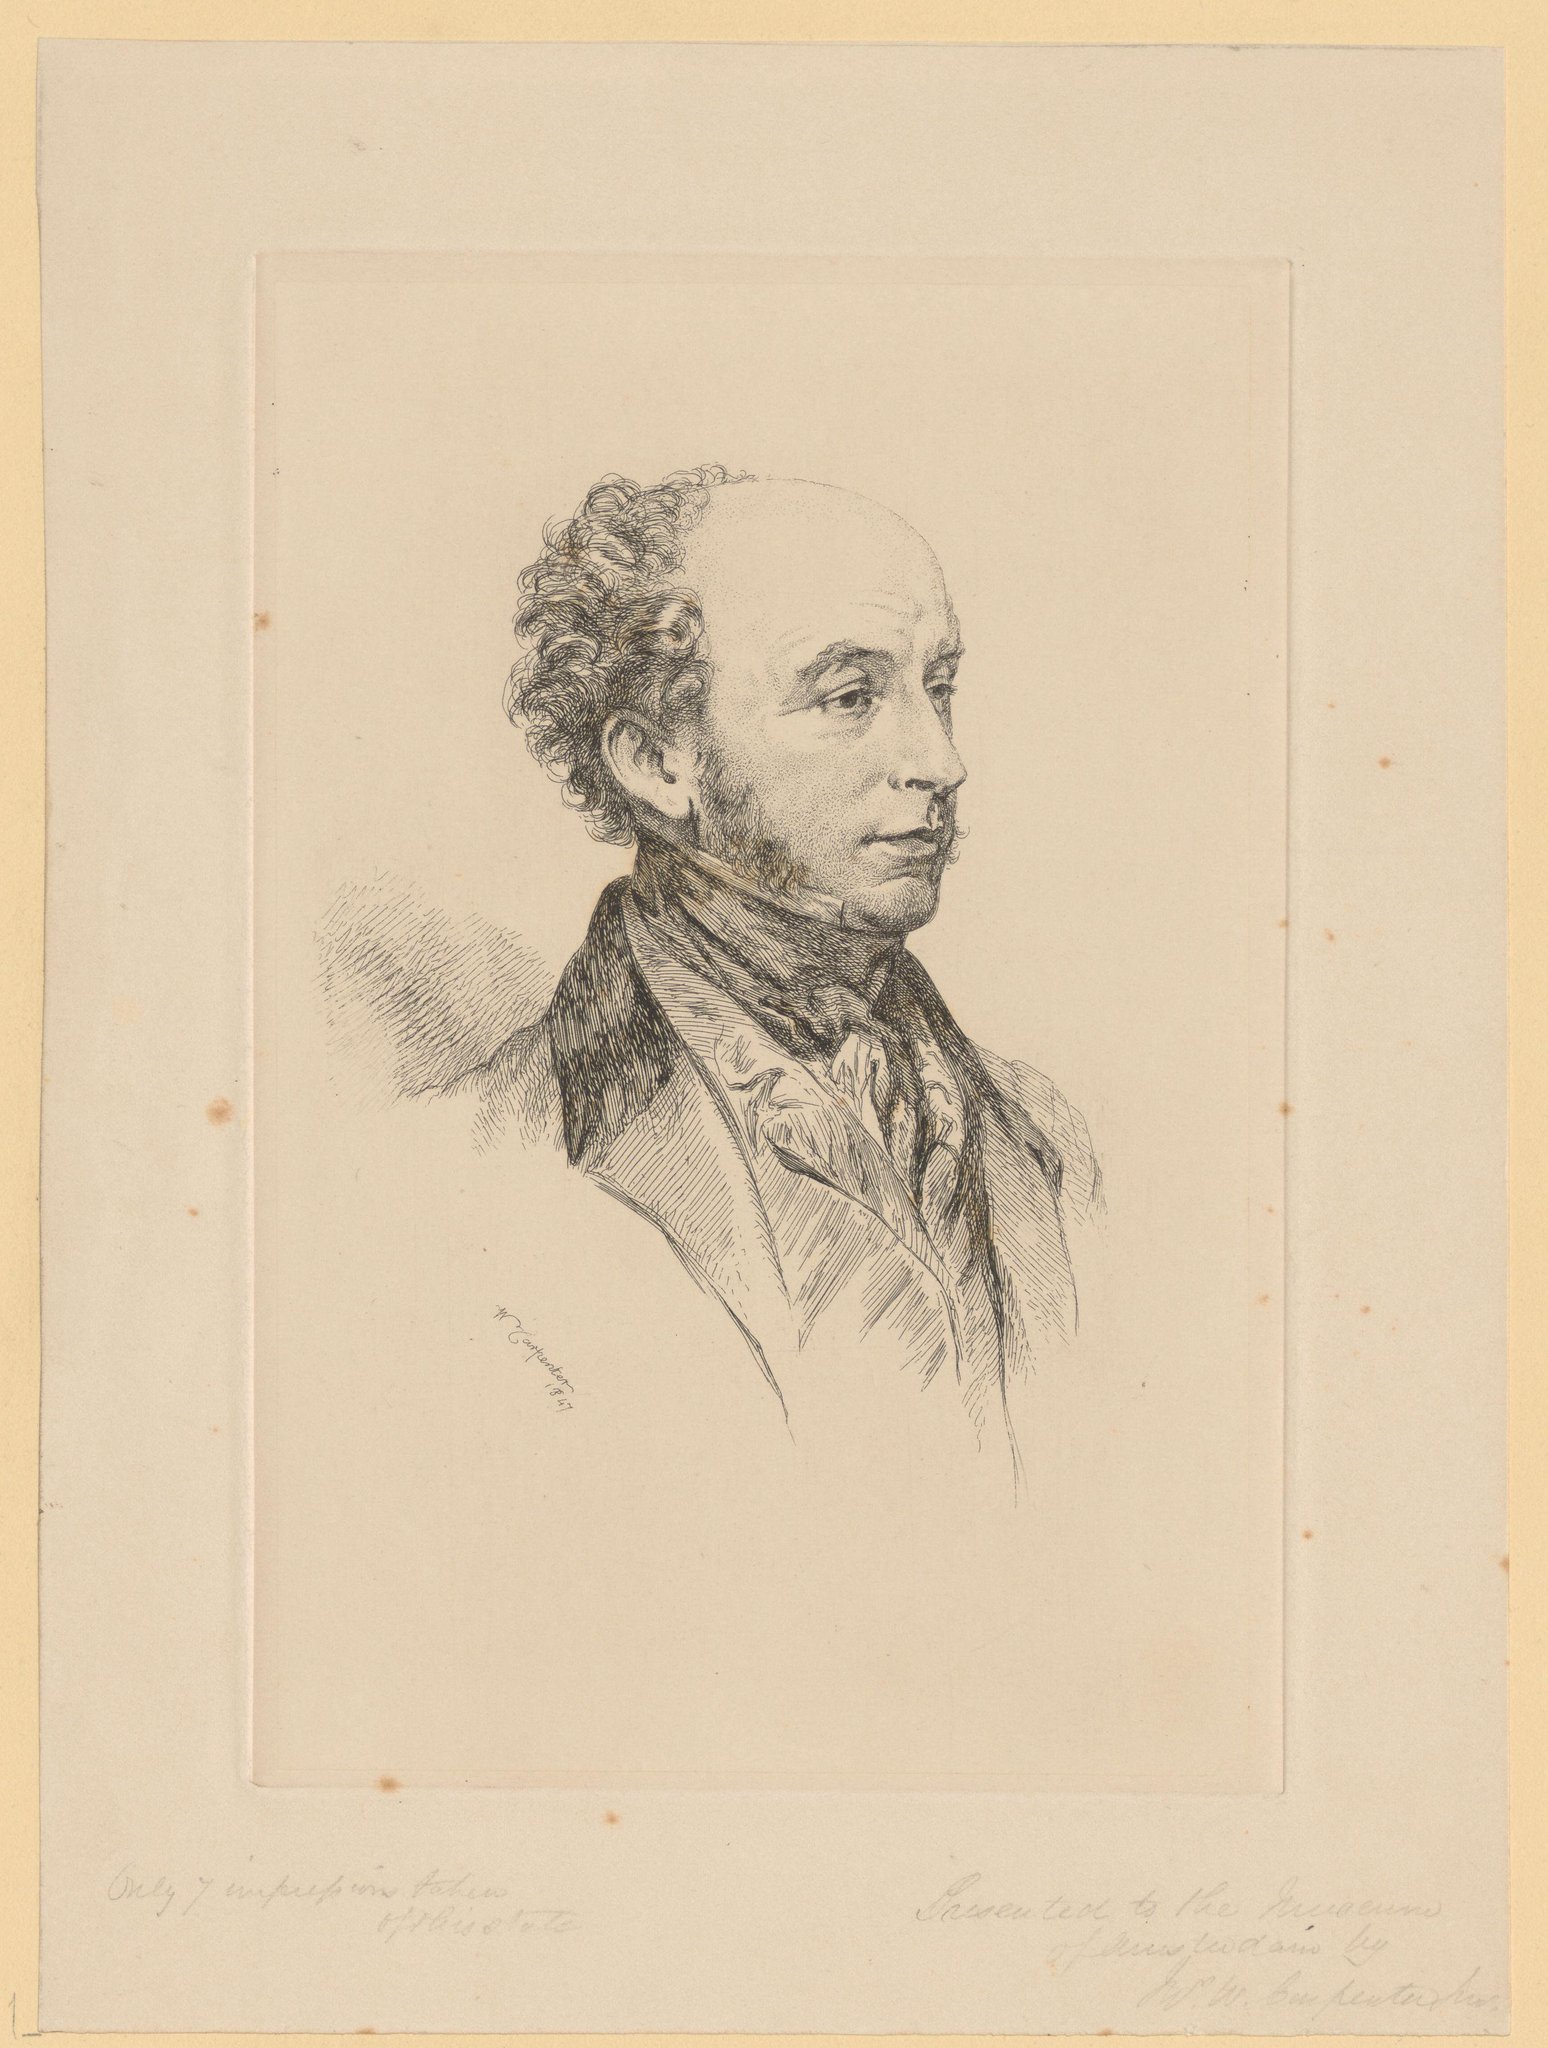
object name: print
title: Portret van William Hookman Carpenter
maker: william carpenter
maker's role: print maker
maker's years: 1818-1899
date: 1847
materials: paper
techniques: etching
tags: london, museum personnel, historical persons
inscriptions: annotation, collector's mark: Lugt 12